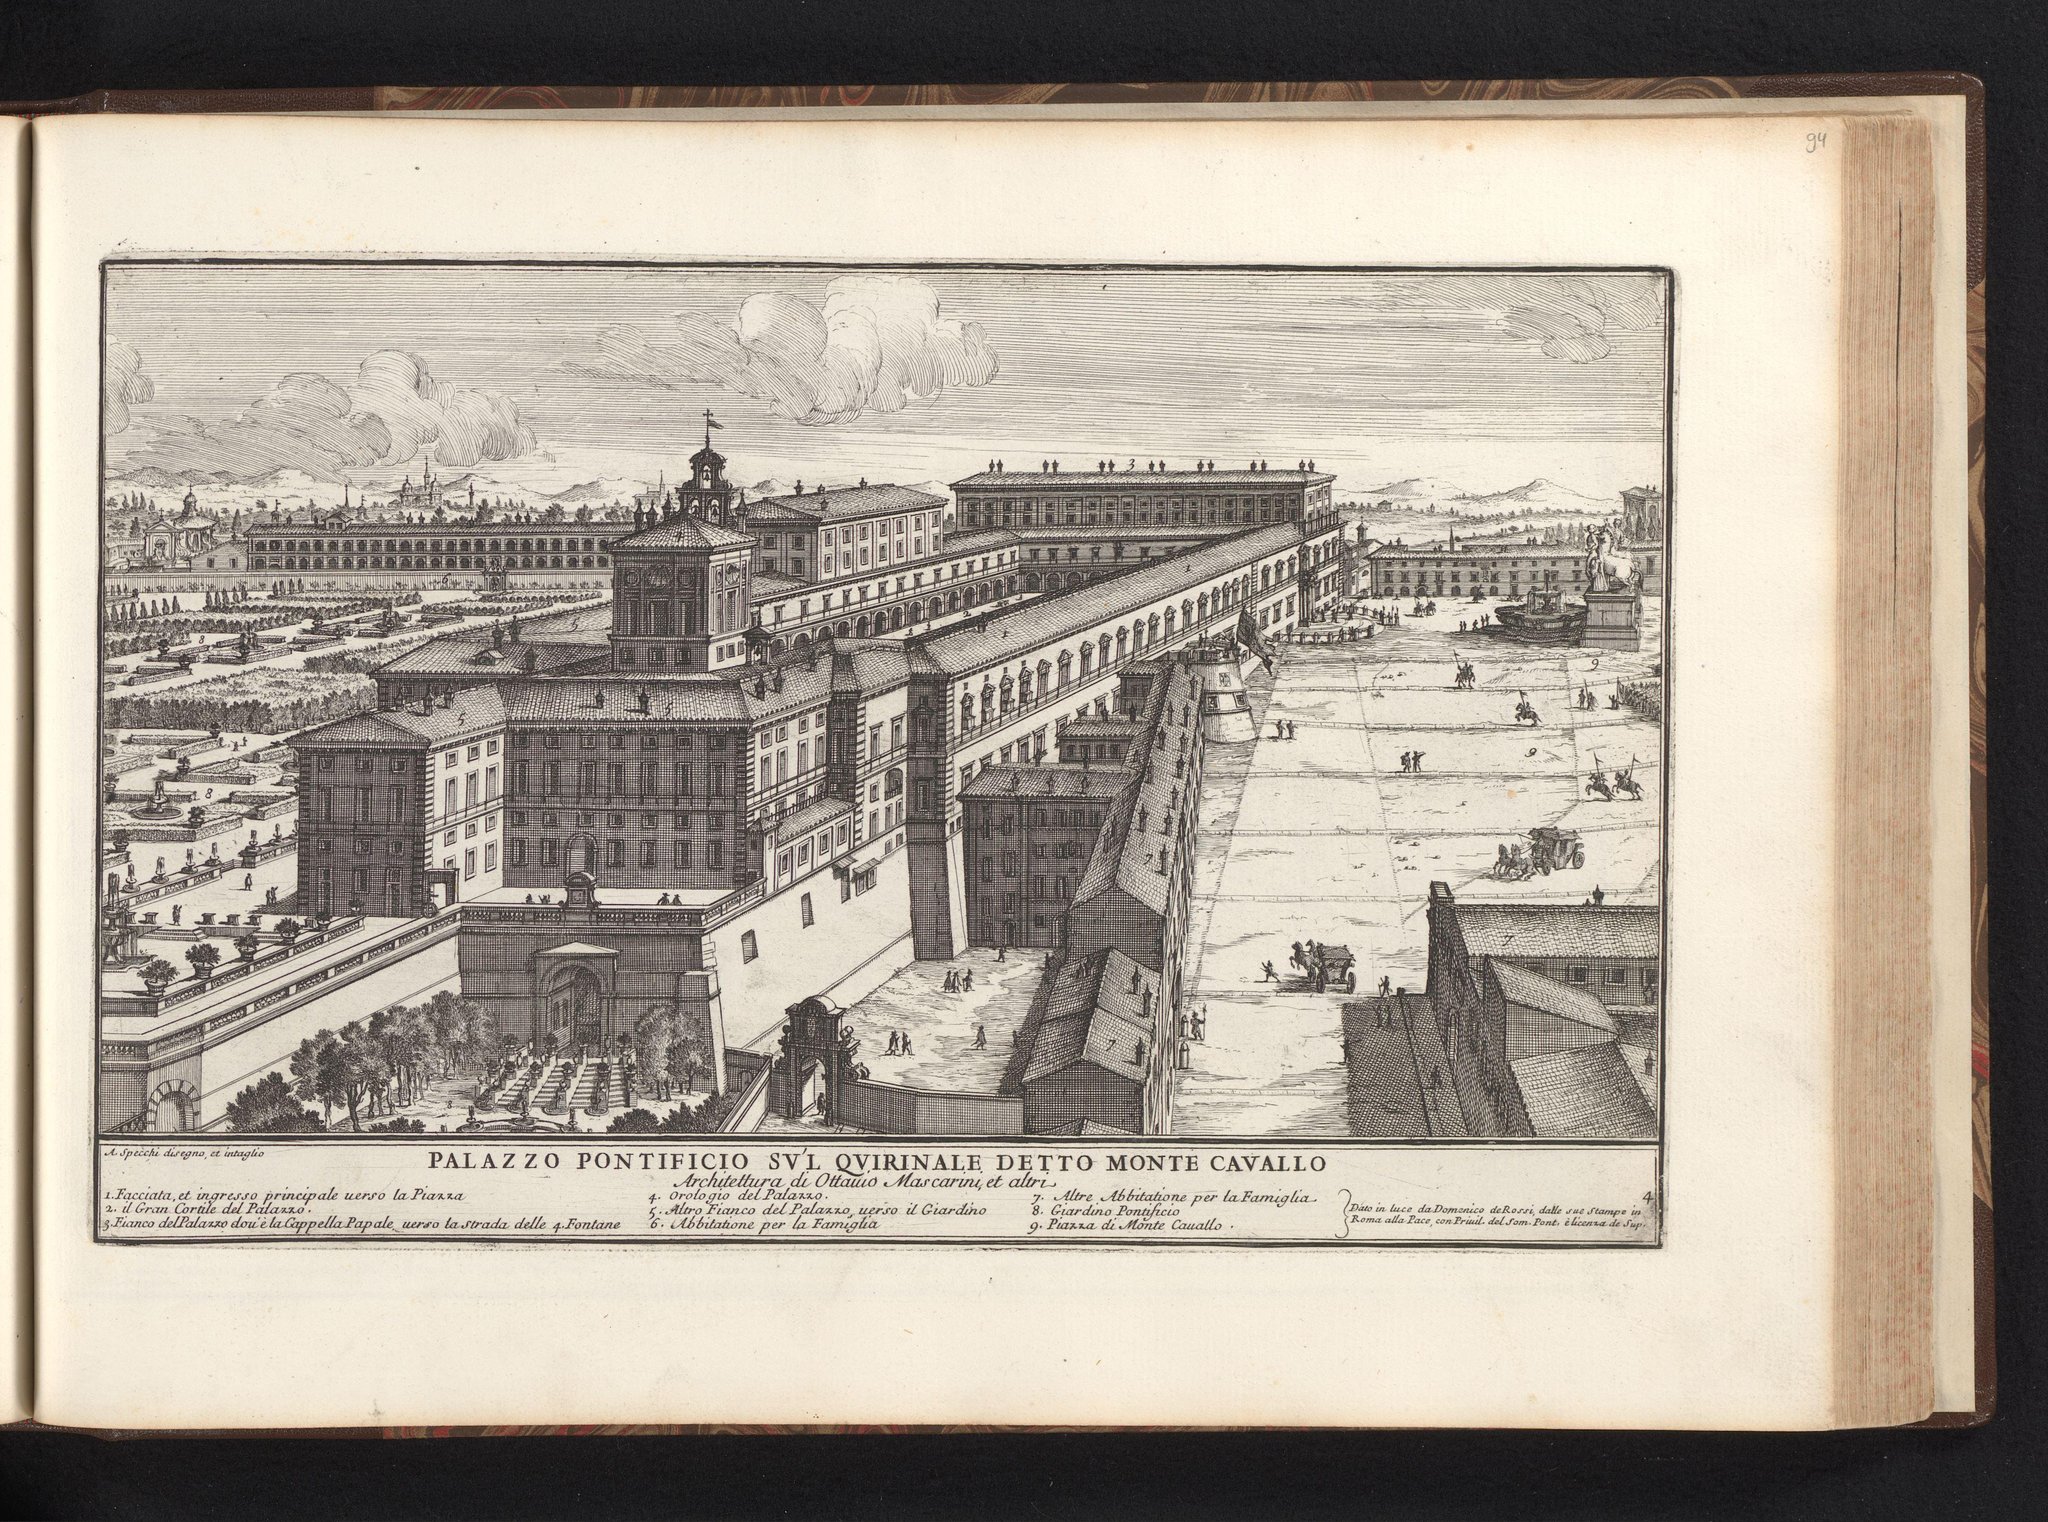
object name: print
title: Palazzo Pontificio su'l Quirinale detto Monte Cavallo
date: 1699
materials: paper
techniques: etching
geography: vatican city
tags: palace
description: Deze prent maakt deel uit van een reeks van 52 prenten met voorstellingen van paleizen in Rome. Samen met vier andere reeksen vormt het de grote reeks: 'Il nuovo teatro di Roma moderna'.